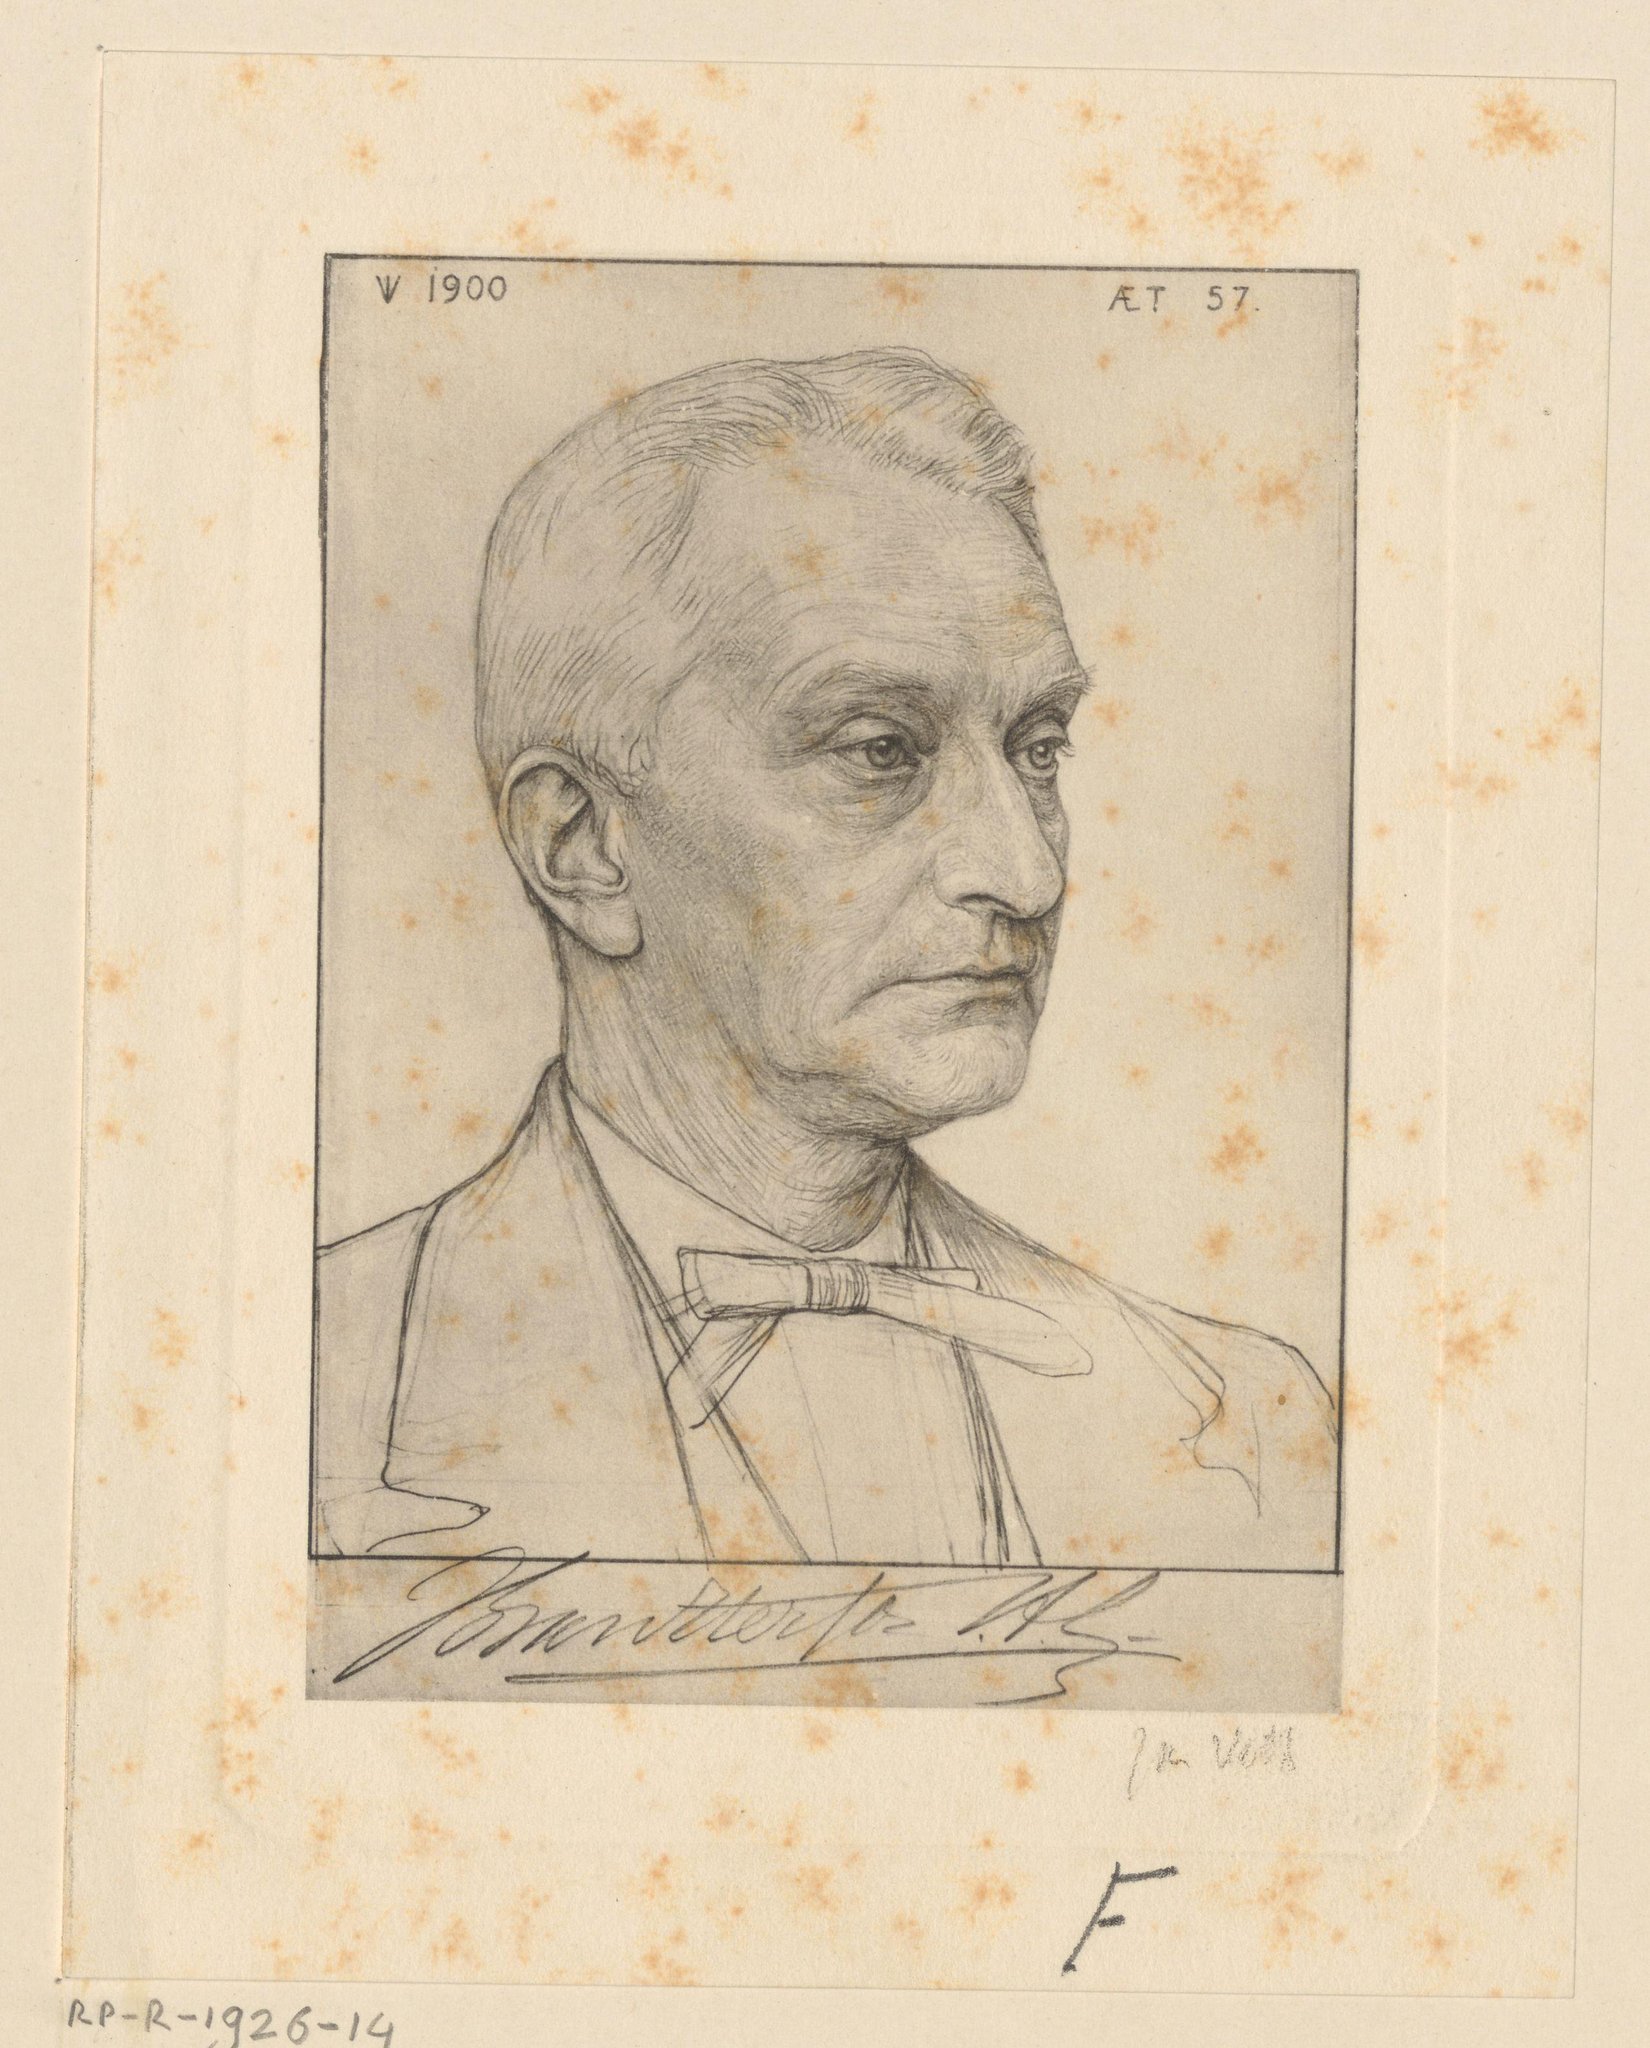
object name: reproduction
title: Portret van Jan Egens van Iterson op 57-jarige leeftijd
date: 1900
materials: paper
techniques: photograph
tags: historical persons, professor